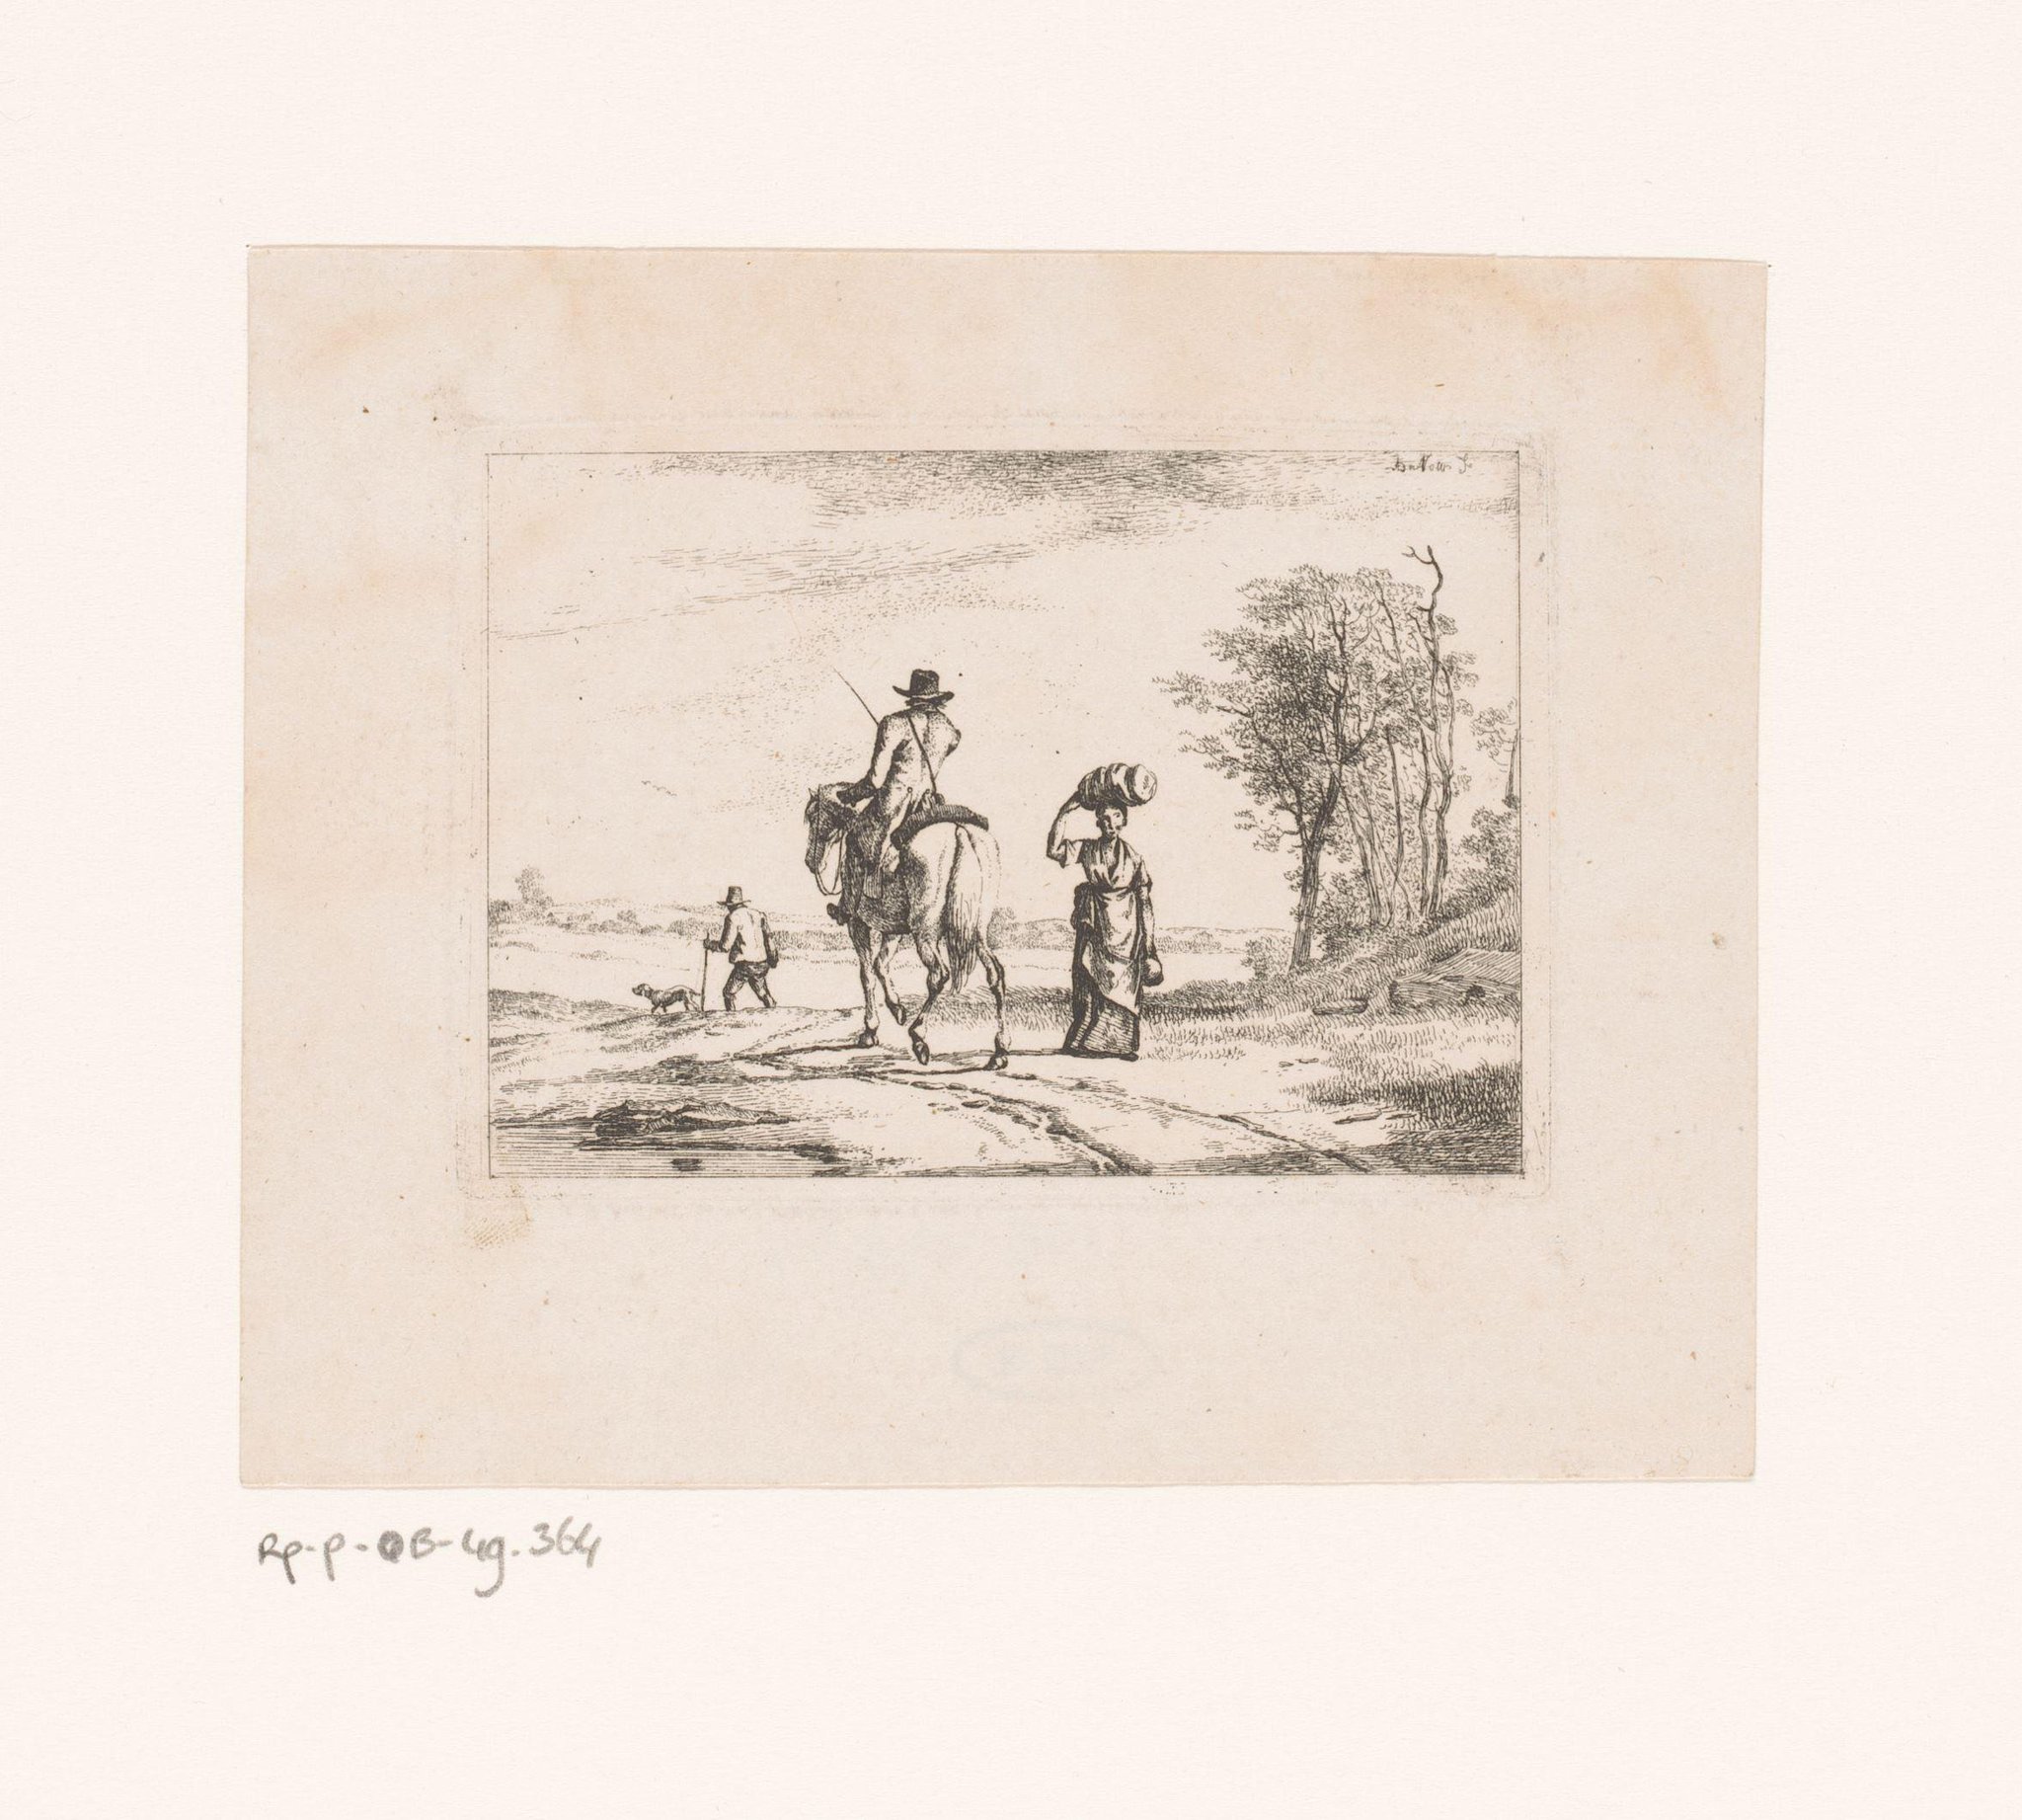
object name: print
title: Landschap met figuren op een weg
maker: auguste herman marie de noter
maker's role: print maker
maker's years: 1806-1838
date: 1829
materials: paper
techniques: etching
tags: riding a horse, ass, or mule; rider, horseman, road, path, landscapes (+ landscape with figures, staffage), carrying something on the head or on the shoulders, dog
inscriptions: collector's mark: Lugt 2228